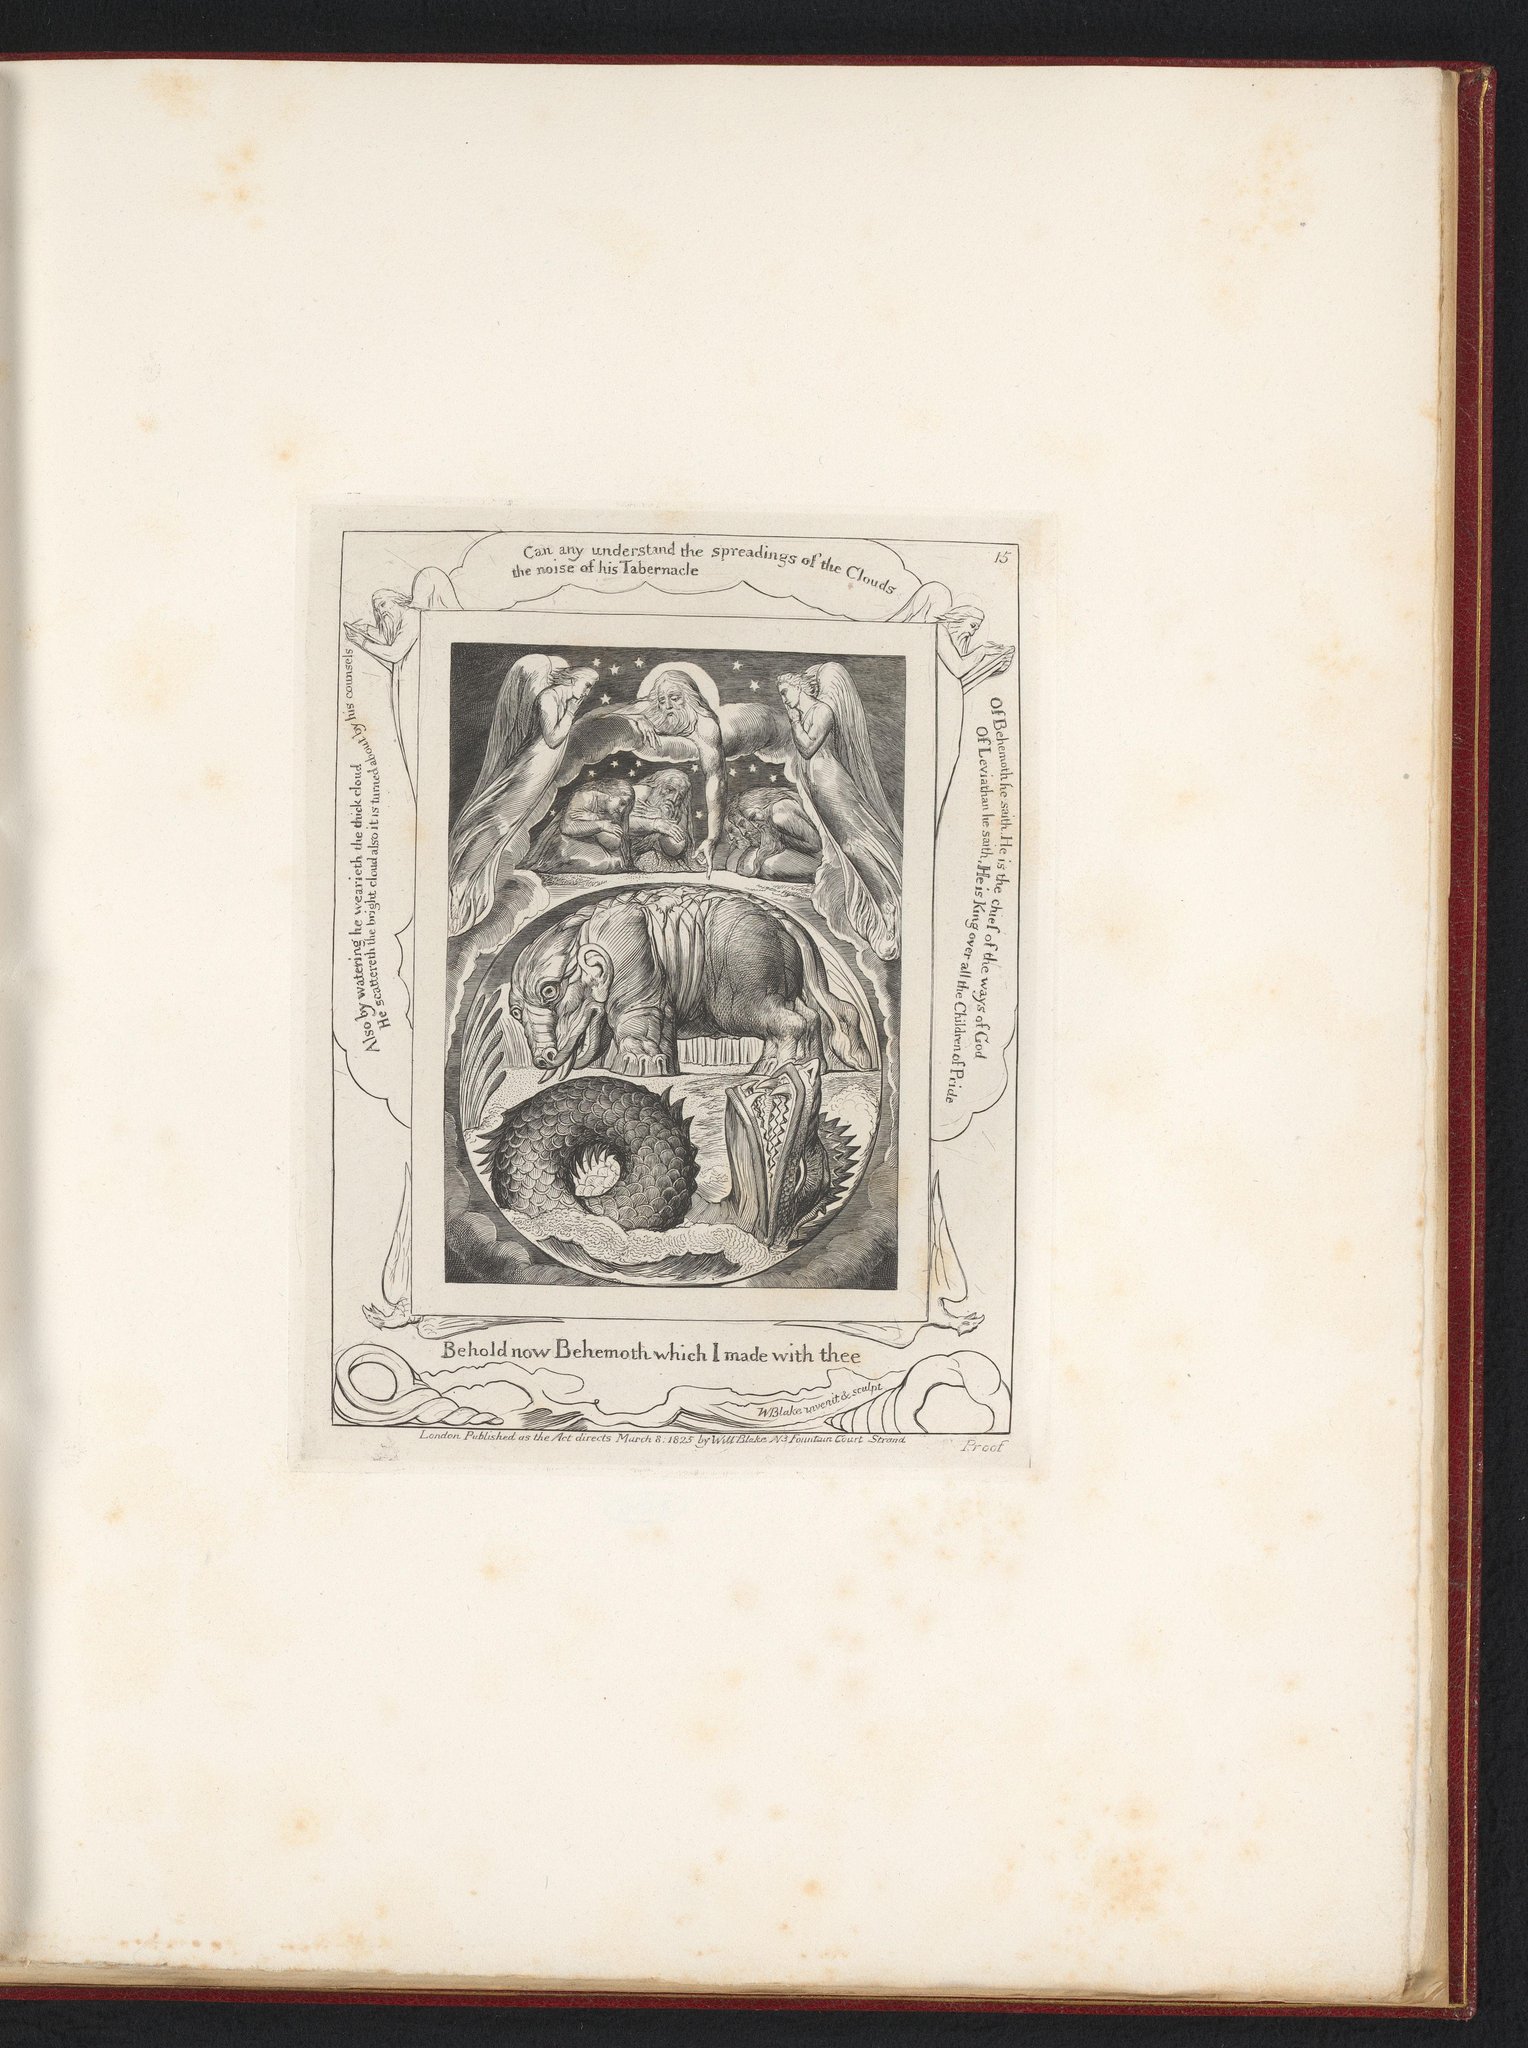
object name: album leaf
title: The Book of Job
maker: william blake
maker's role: print maker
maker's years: 1757-1827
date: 1825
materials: paper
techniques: engraving, etching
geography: london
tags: 'behold behemoth' ~ god speaks to job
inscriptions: collector's mark: Lugt 2228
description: Prent maakt deel uit van een serie van 21 prenten. Er bestaan 150 afdrukken van de serie met daarop 'proof'.